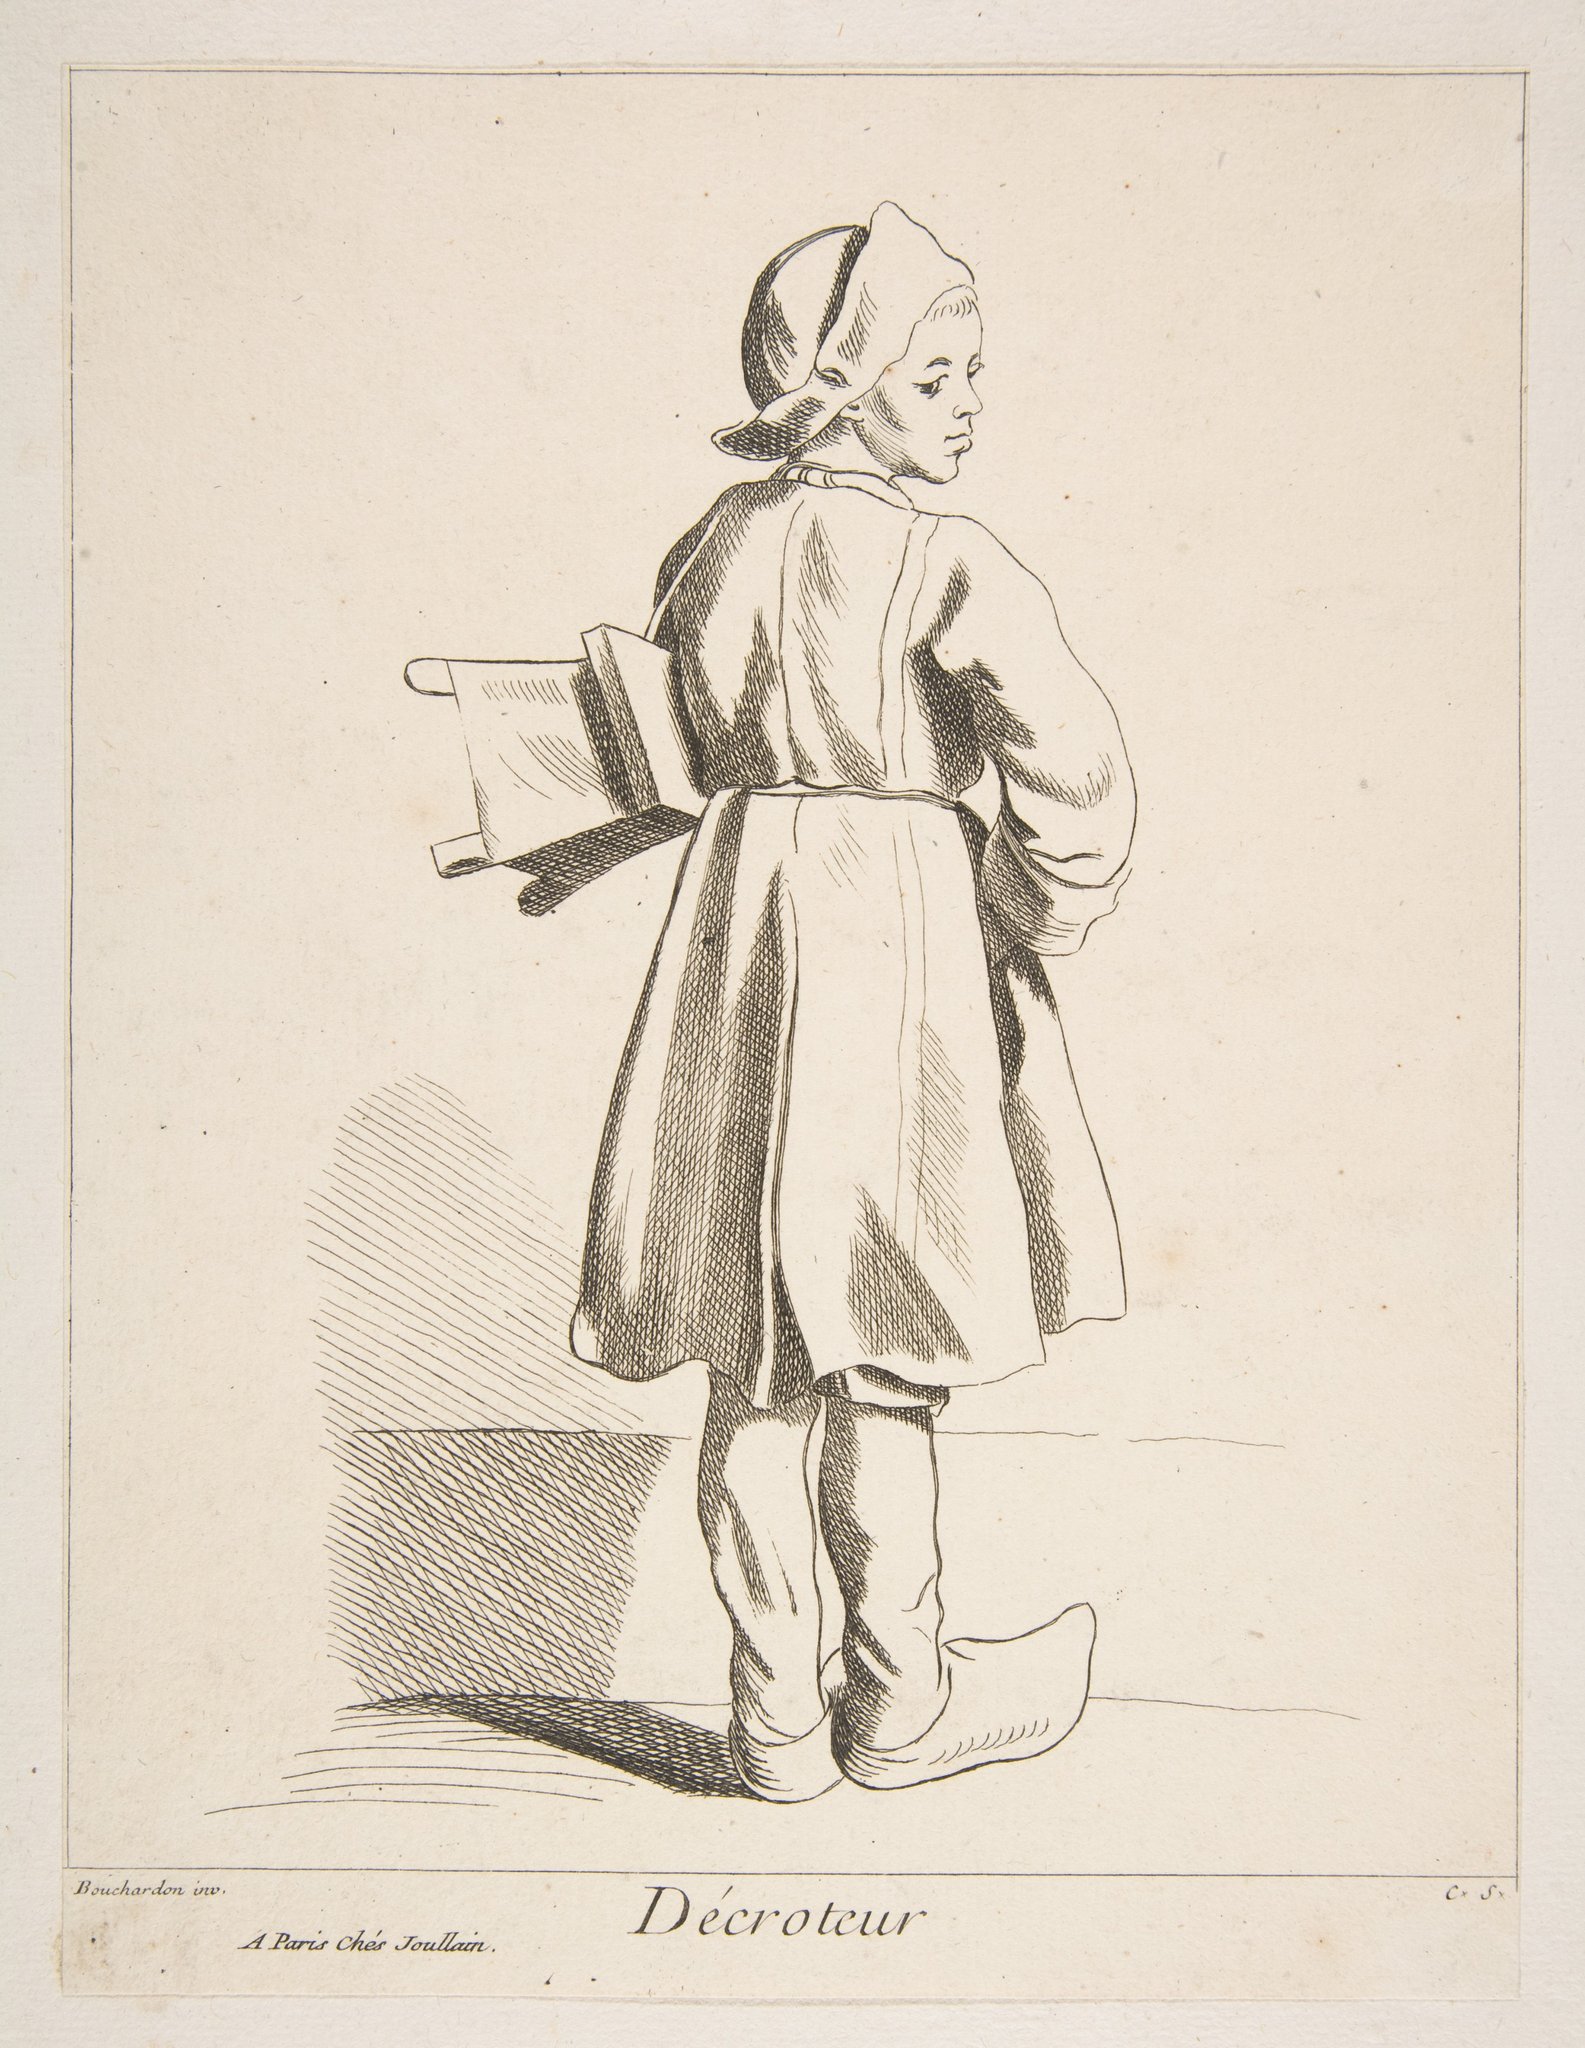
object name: print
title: Shoeblack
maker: anne claude philippe de tubières, comte de caylus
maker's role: artist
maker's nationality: french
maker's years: 1692-1765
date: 1737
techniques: engraving, etching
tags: boys